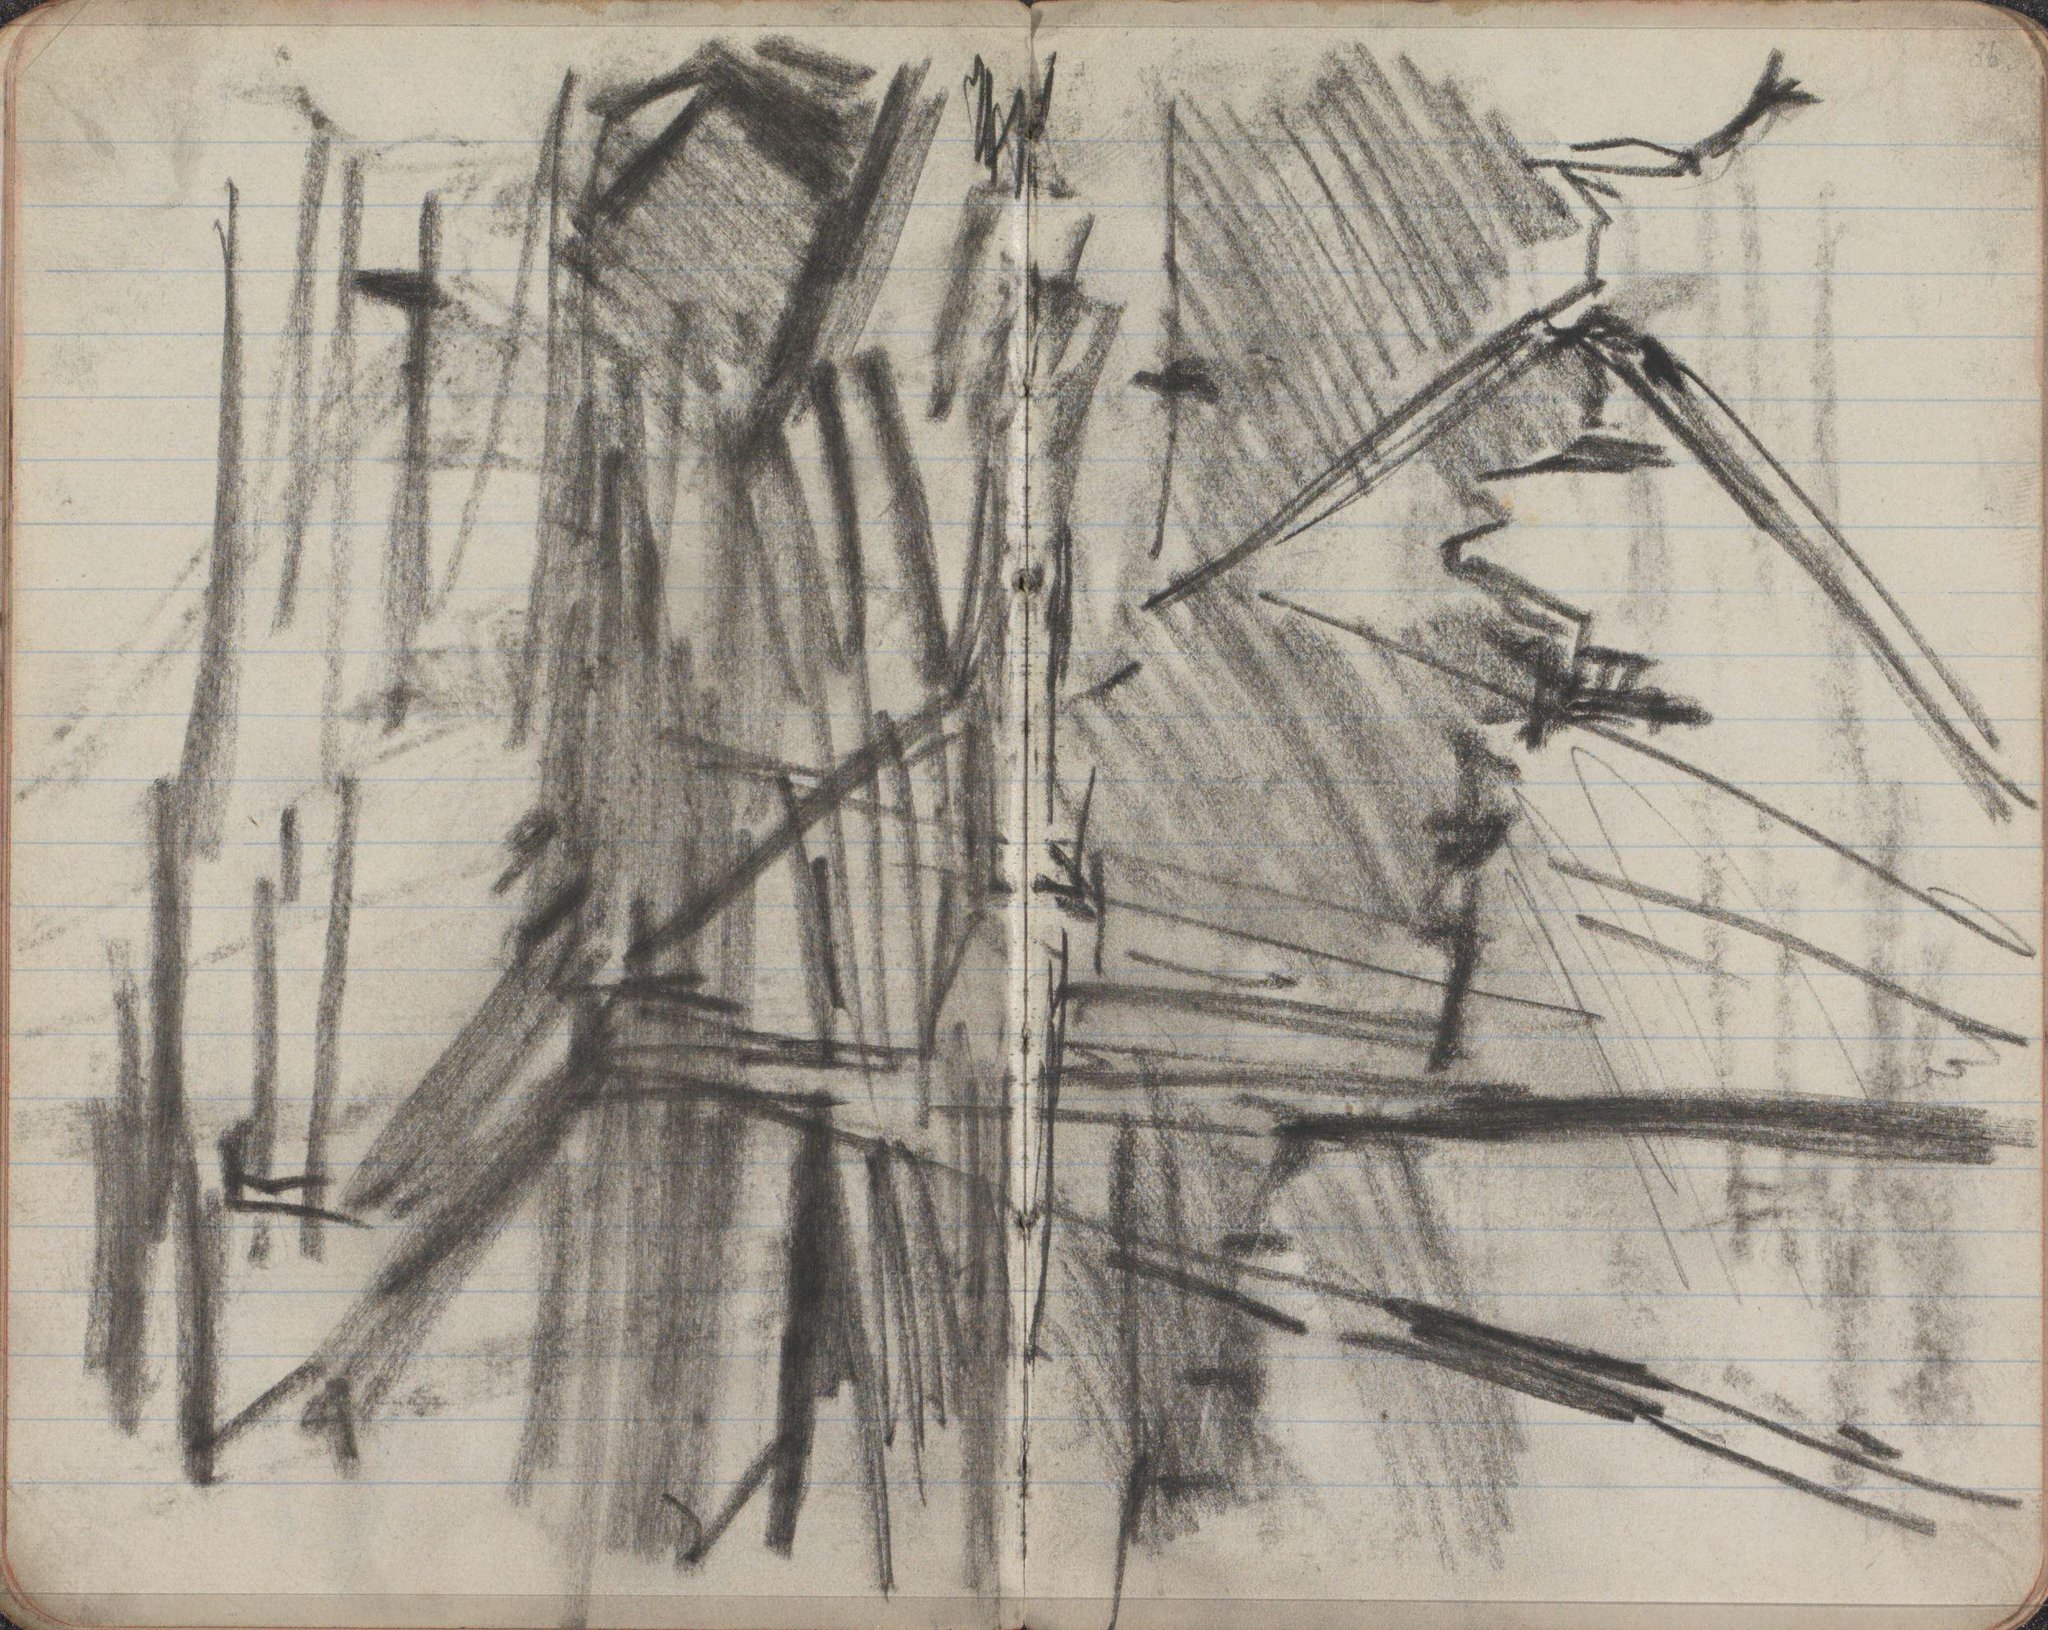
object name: sketchbook leaf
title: Gezicht in Amsterdam met aangemeerde boten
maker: george hendrik breitner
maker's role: draughtsman, painter, print maker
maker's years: 1857-1923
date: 1893-1898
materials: chalk, paper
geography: amsterdam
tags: ships (in general), canals, waters (in city), civic architecture; edifices; dwellings, amsterdam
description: Pagina 35 en pagina 36 uit een schetsboek met 38 bladen.